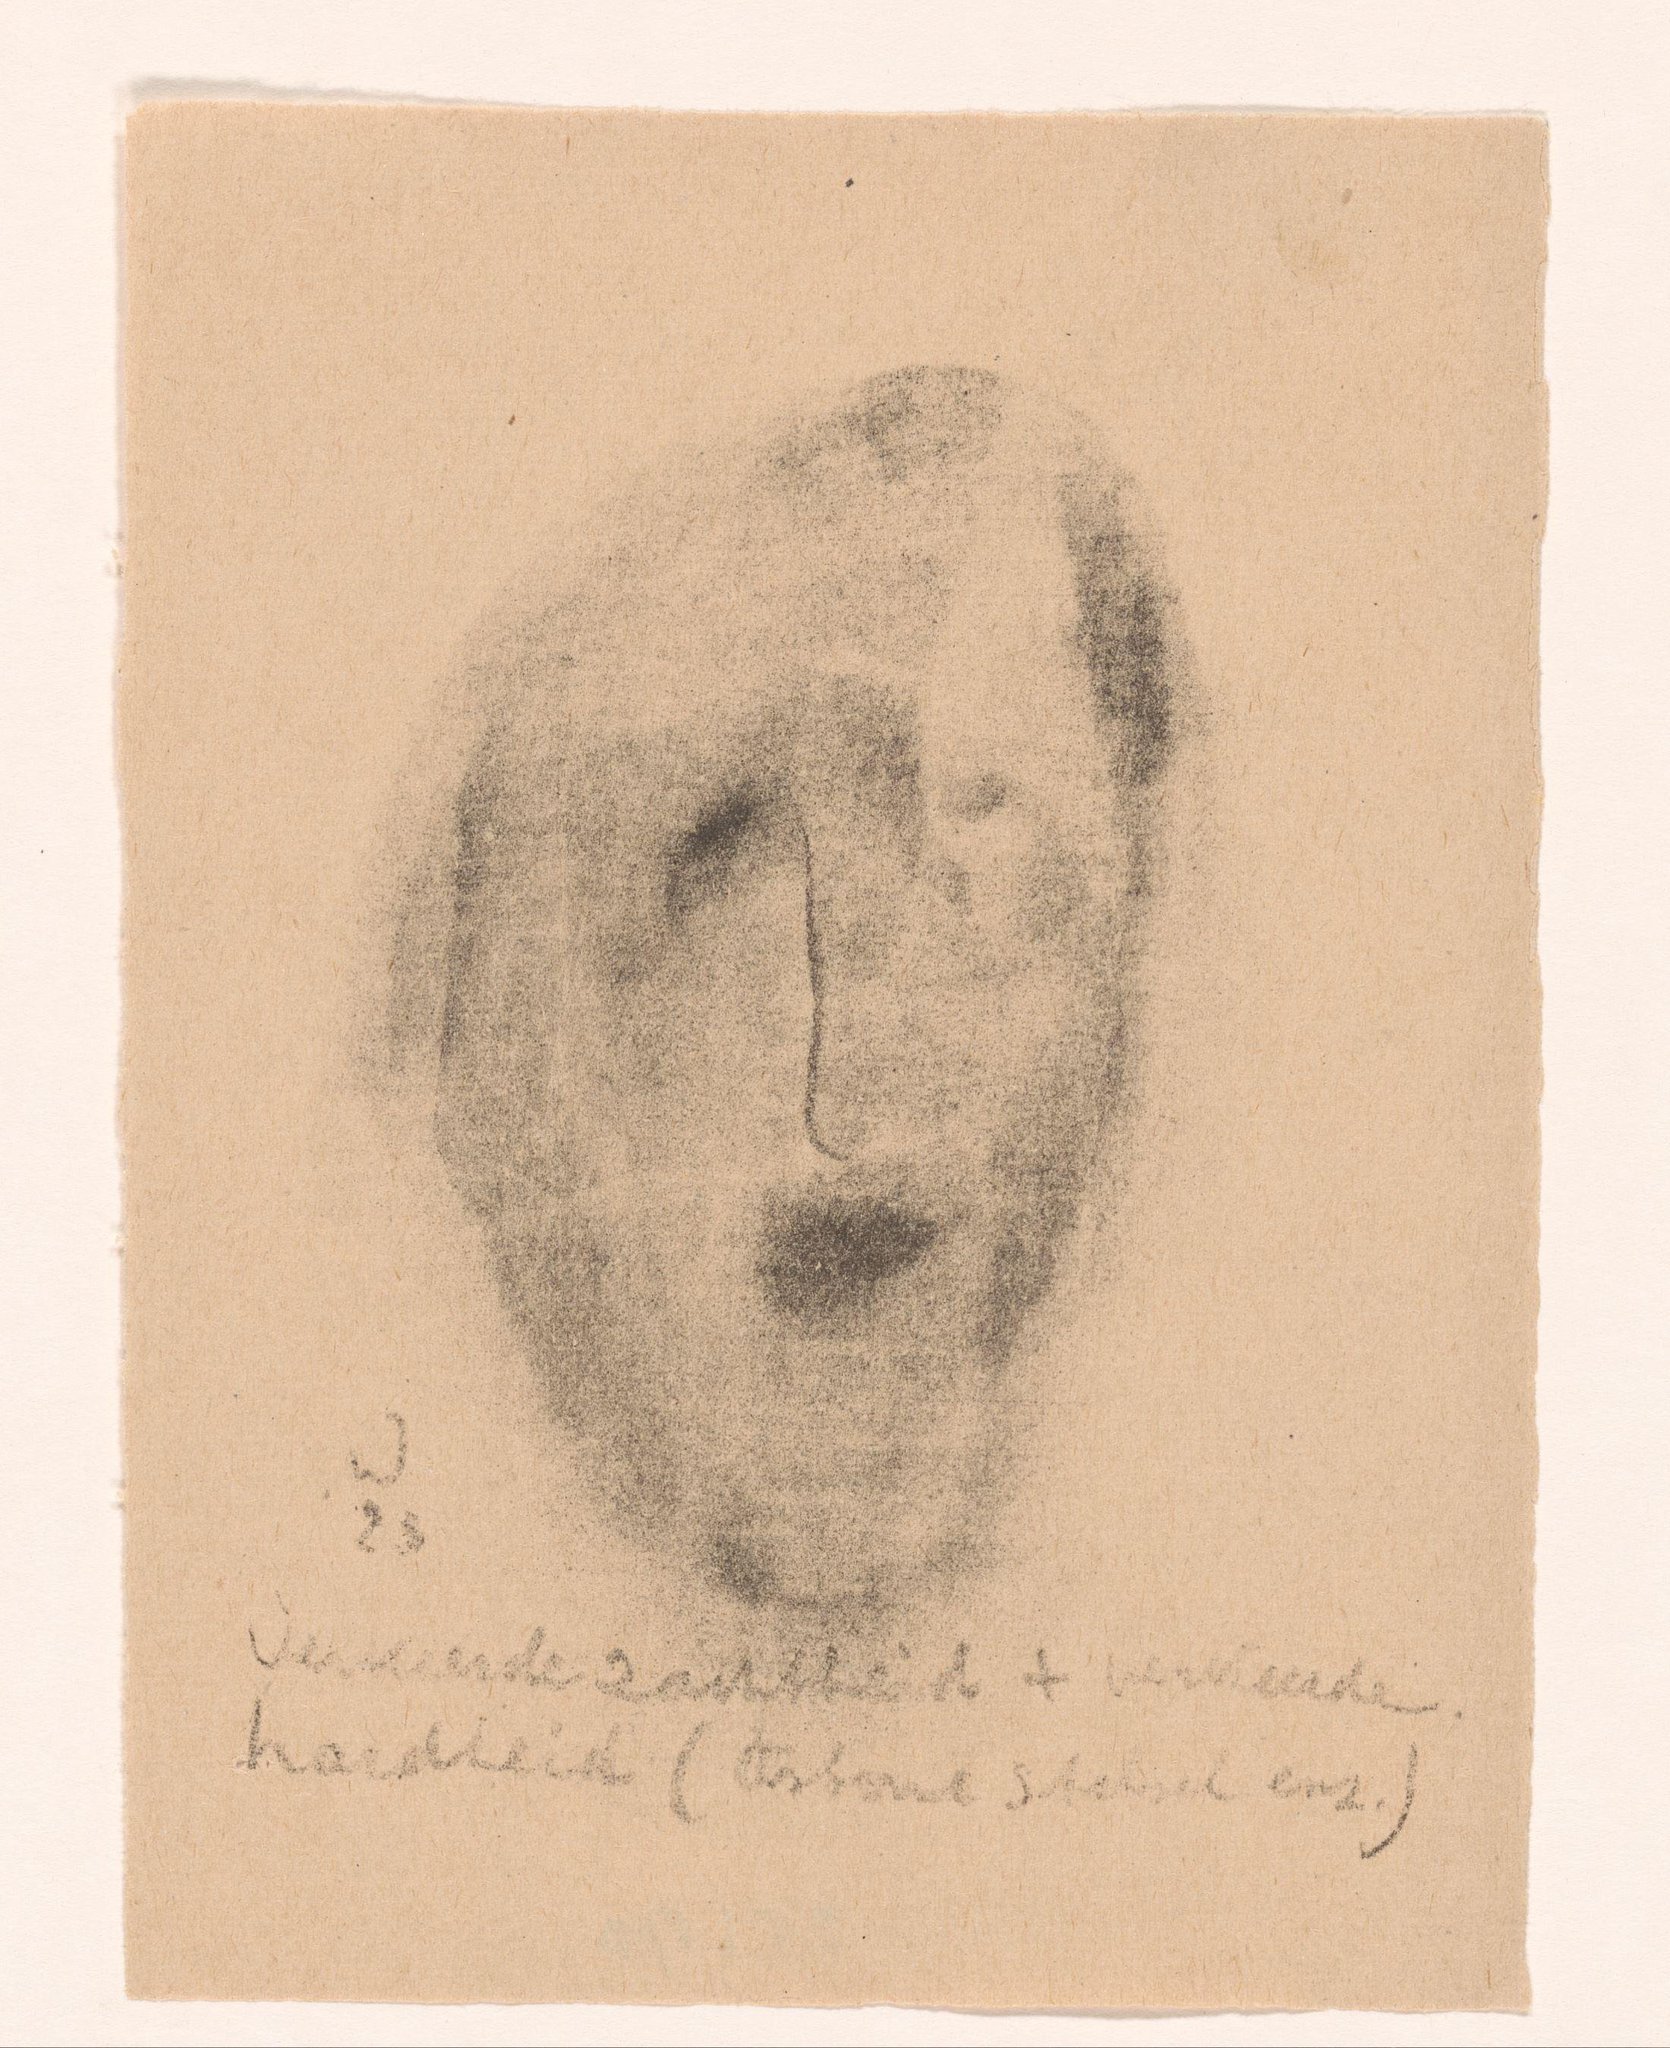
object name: print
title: Idealisten II en verdere Kanttekeningen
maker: erich wichmann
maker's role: print maker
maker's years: 1890-1929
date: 1923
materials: paper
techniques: lithograph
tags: caricatures (human types)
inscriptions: collector's mark: Lugt 2228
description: Onderaan de tekst: 'Verkeerde zachtheid + verkeerde hardheid (Asbone stelsel enz.)'.